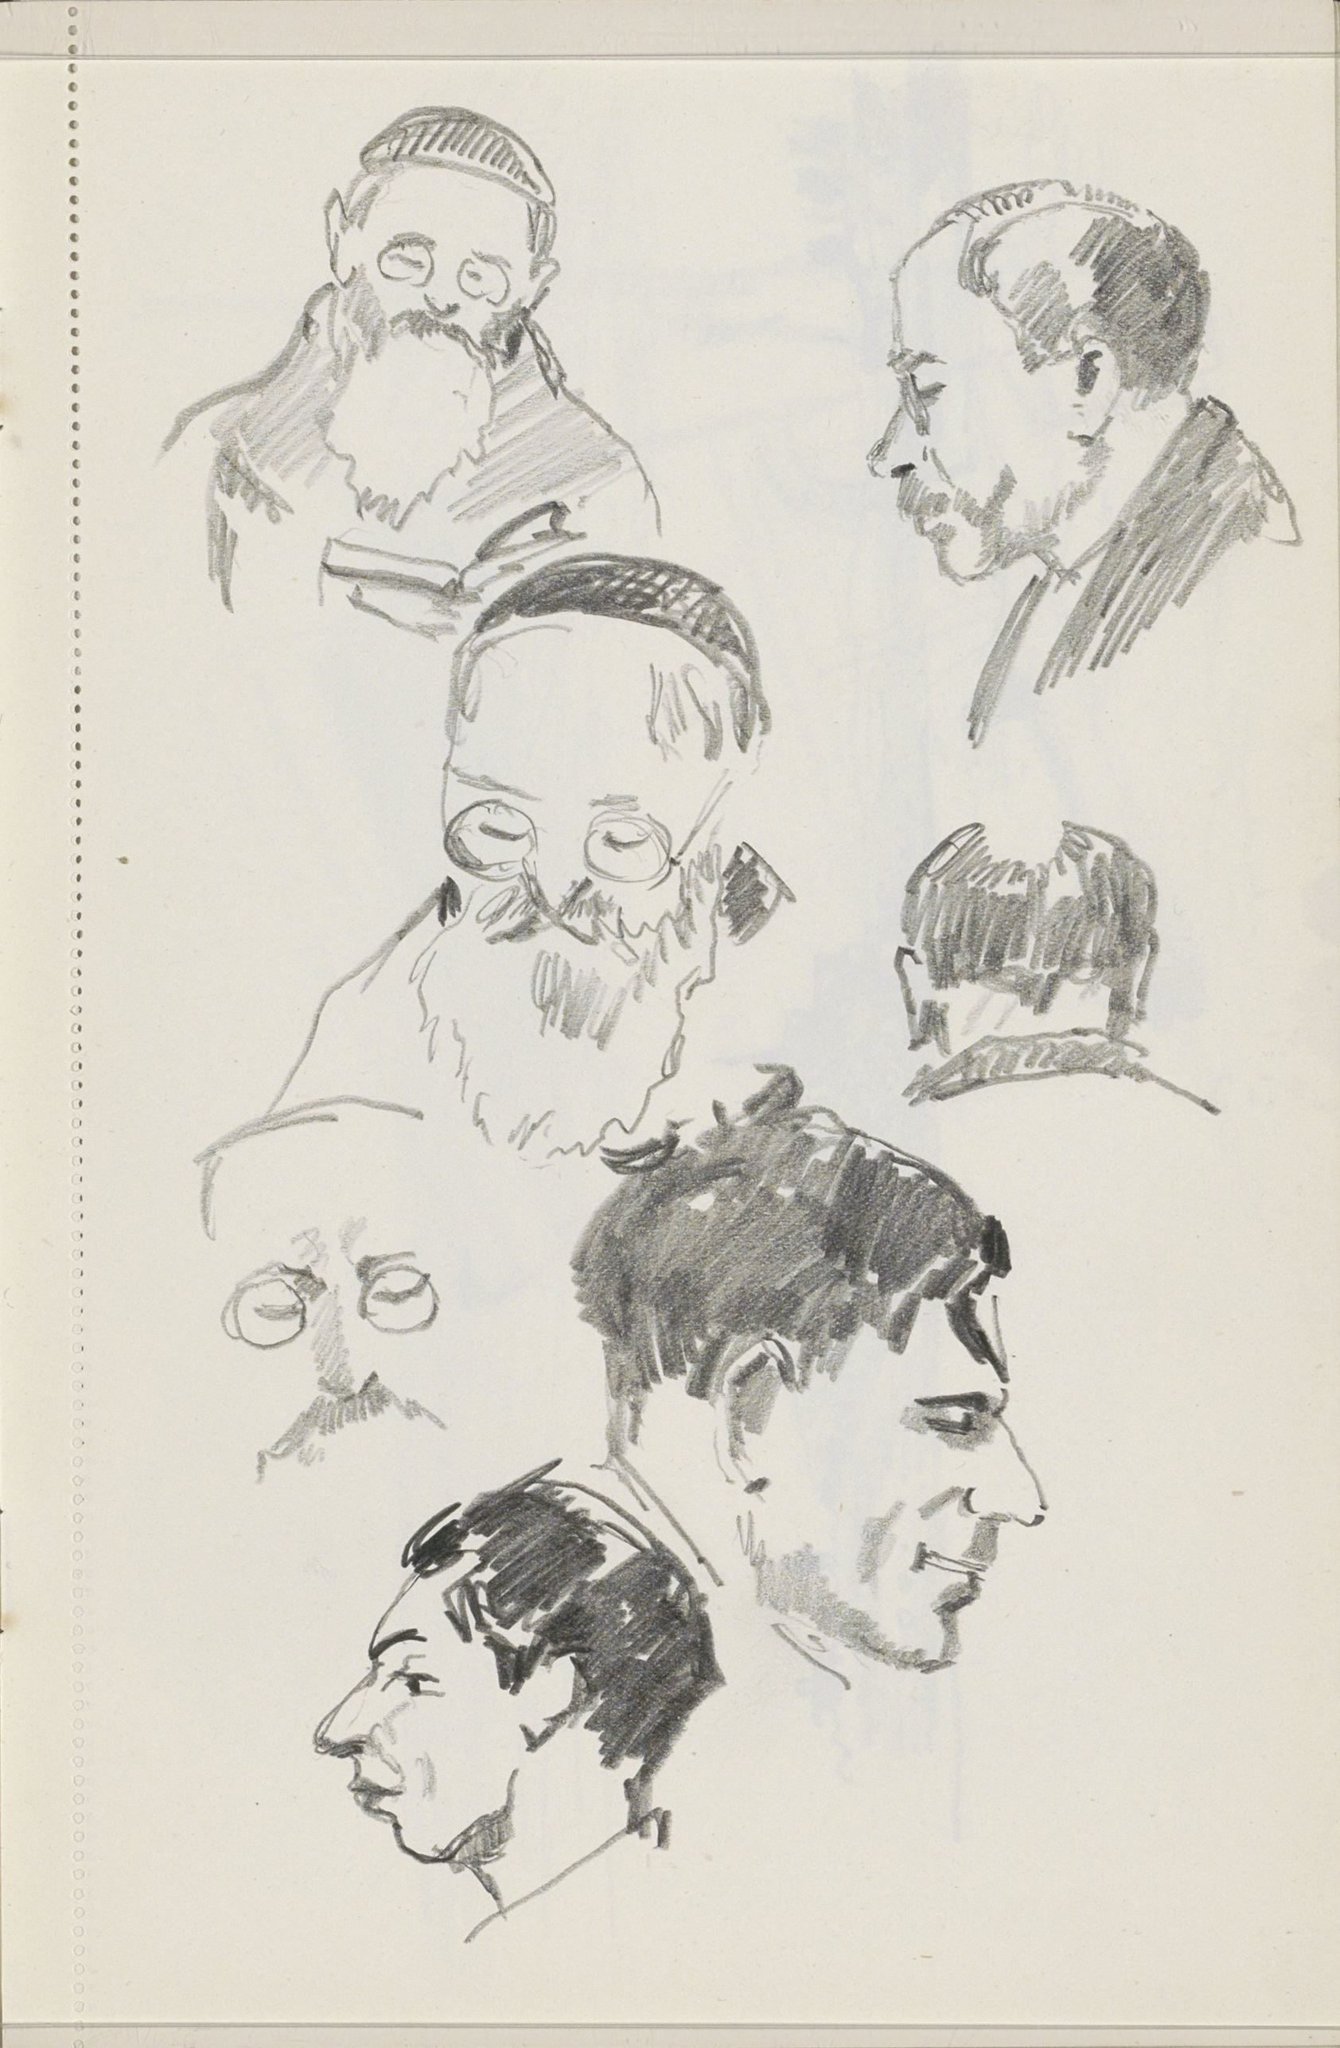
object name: sketchbook leaf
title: Mannenkoppen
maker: cornelis vreedenburgh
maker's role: draughtsman, print maker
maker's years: 1880-1946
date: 1936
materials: paper, pencil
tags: head (human)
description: De mannen dragen hoofddeksels. Blad 23 recto uit een schetsboek met 73 bladen.